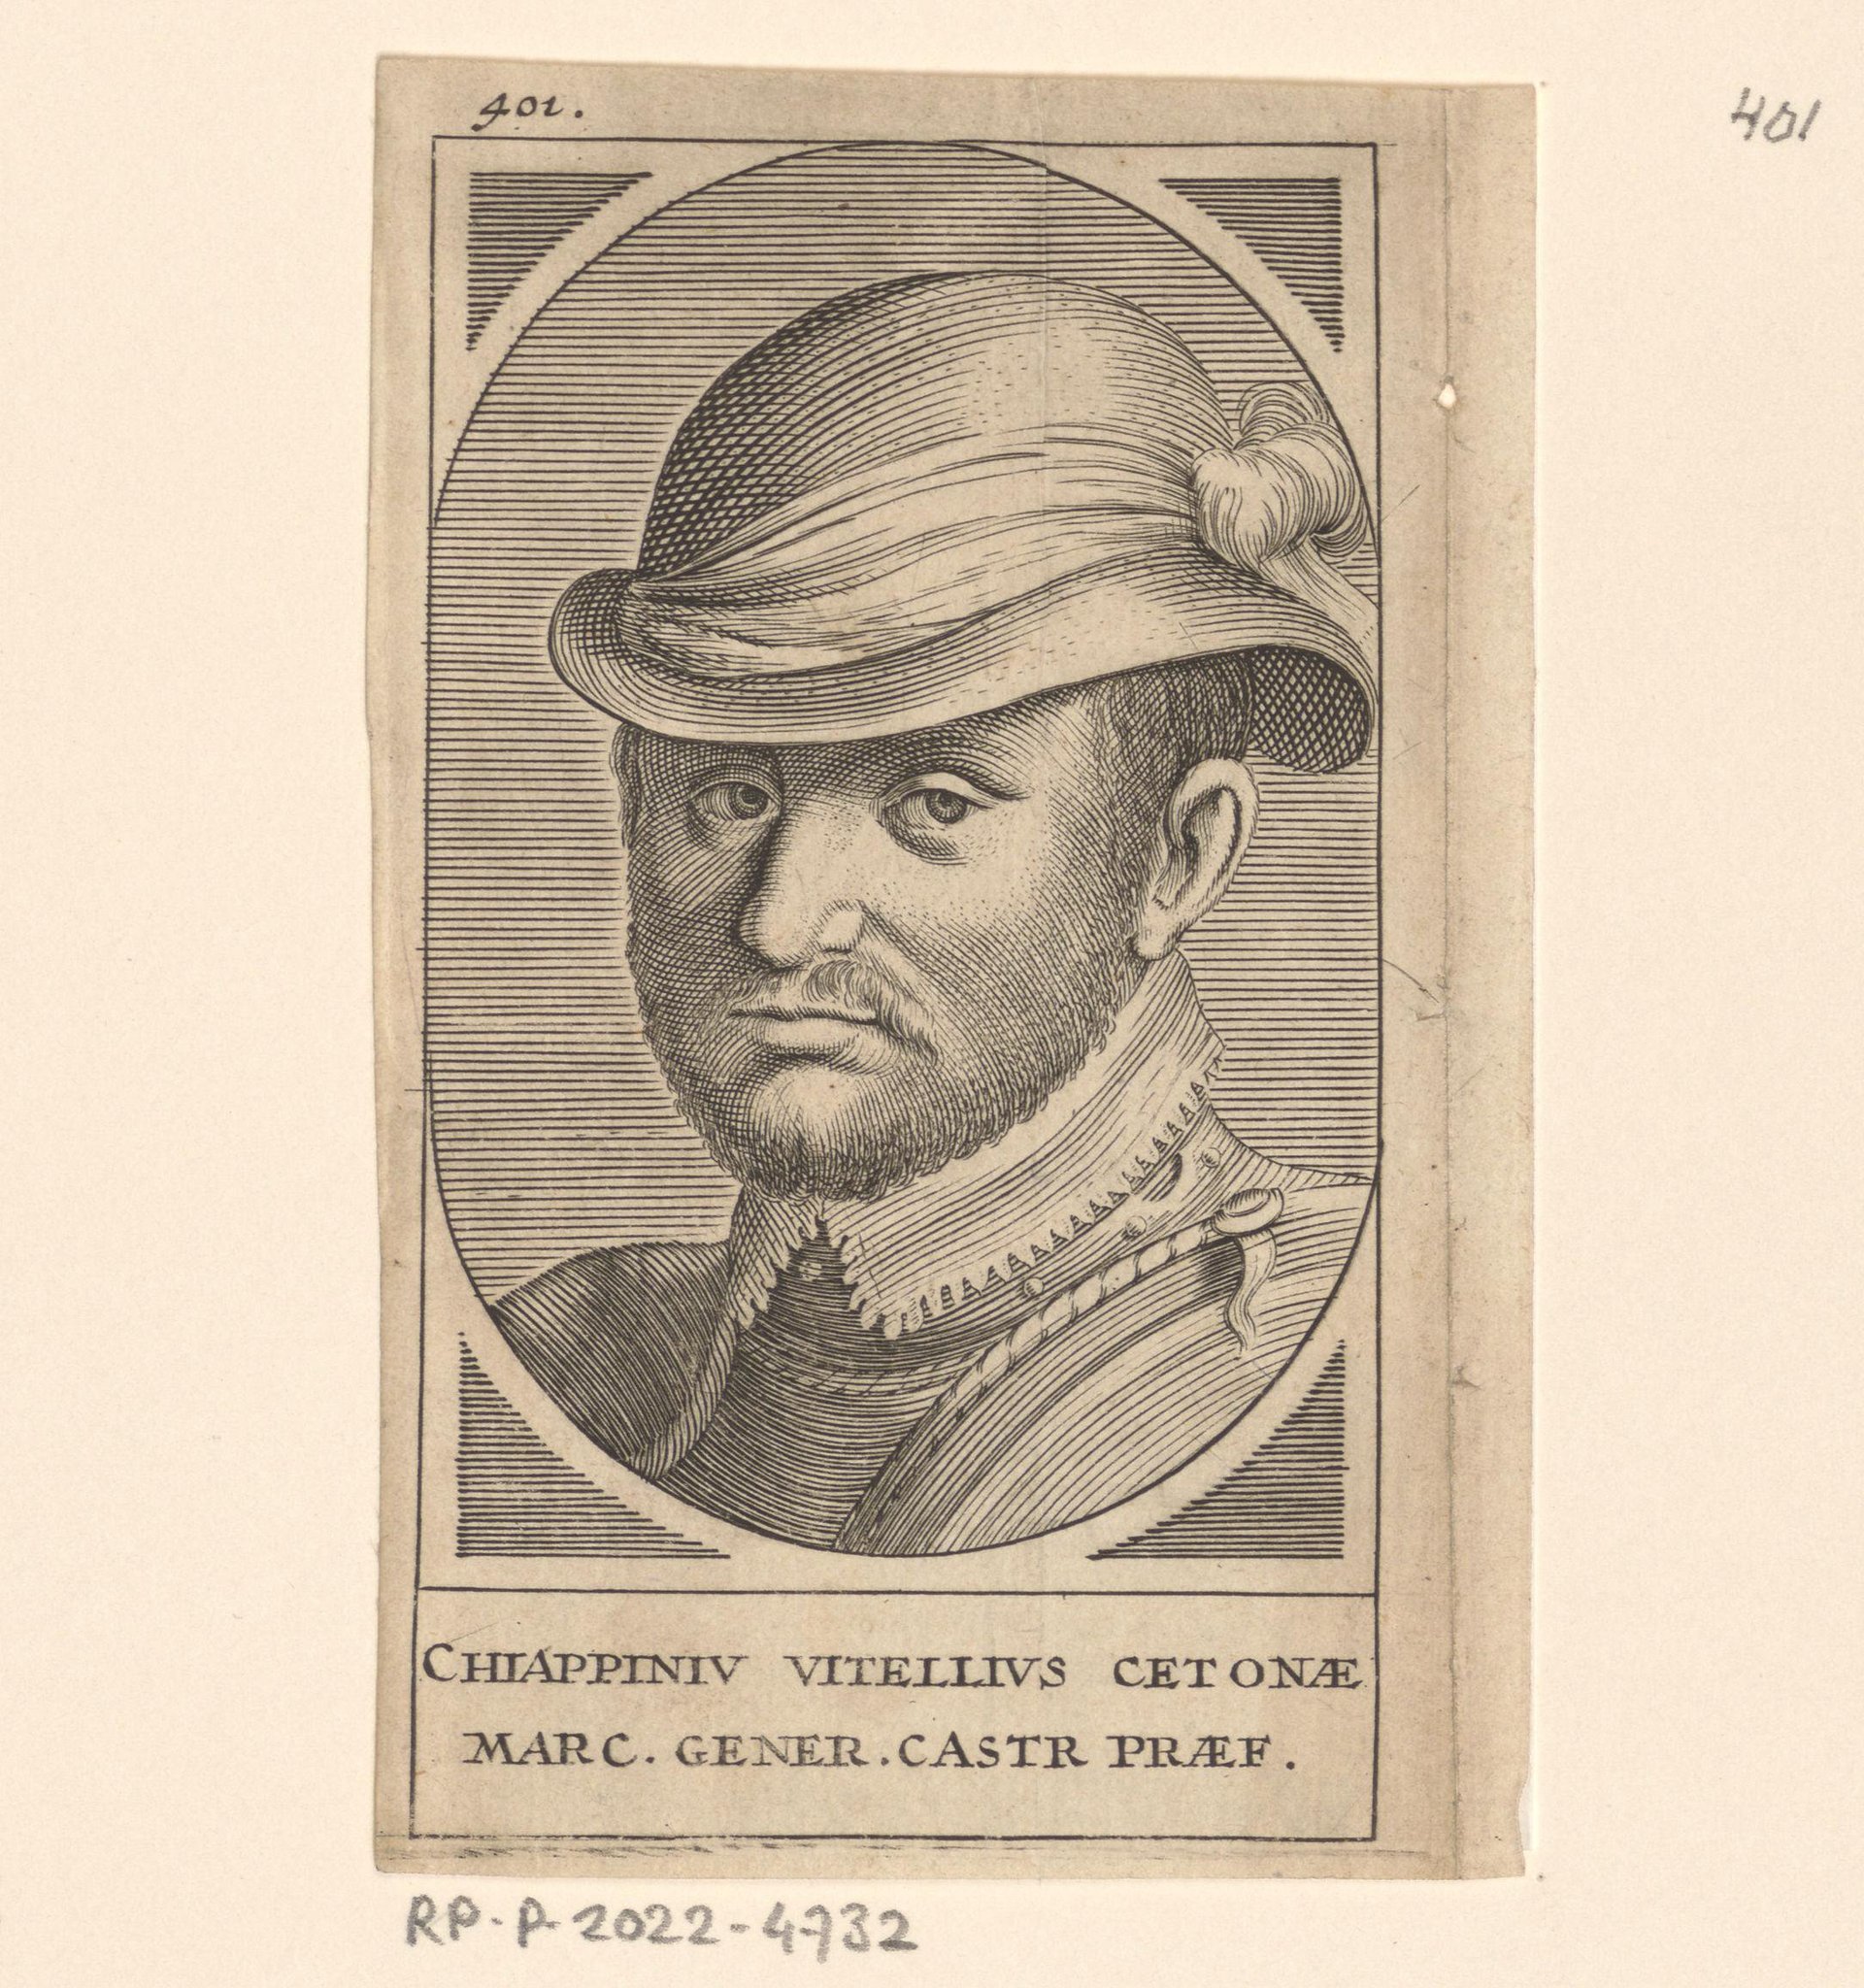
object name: print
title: Portret van Giovan Luigi Vitelli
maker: Anonymous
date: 1645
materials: paper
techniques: engraving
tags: commander-in-chief, general, marshal, historical persons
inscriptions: collector's mark: Lugt 2228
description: Prent waarschijnlijk uit: Strada, Famiano. De bello belgico (...). Leiden: Jacob Marcus, 1645, dl. 1, p. 400-401.